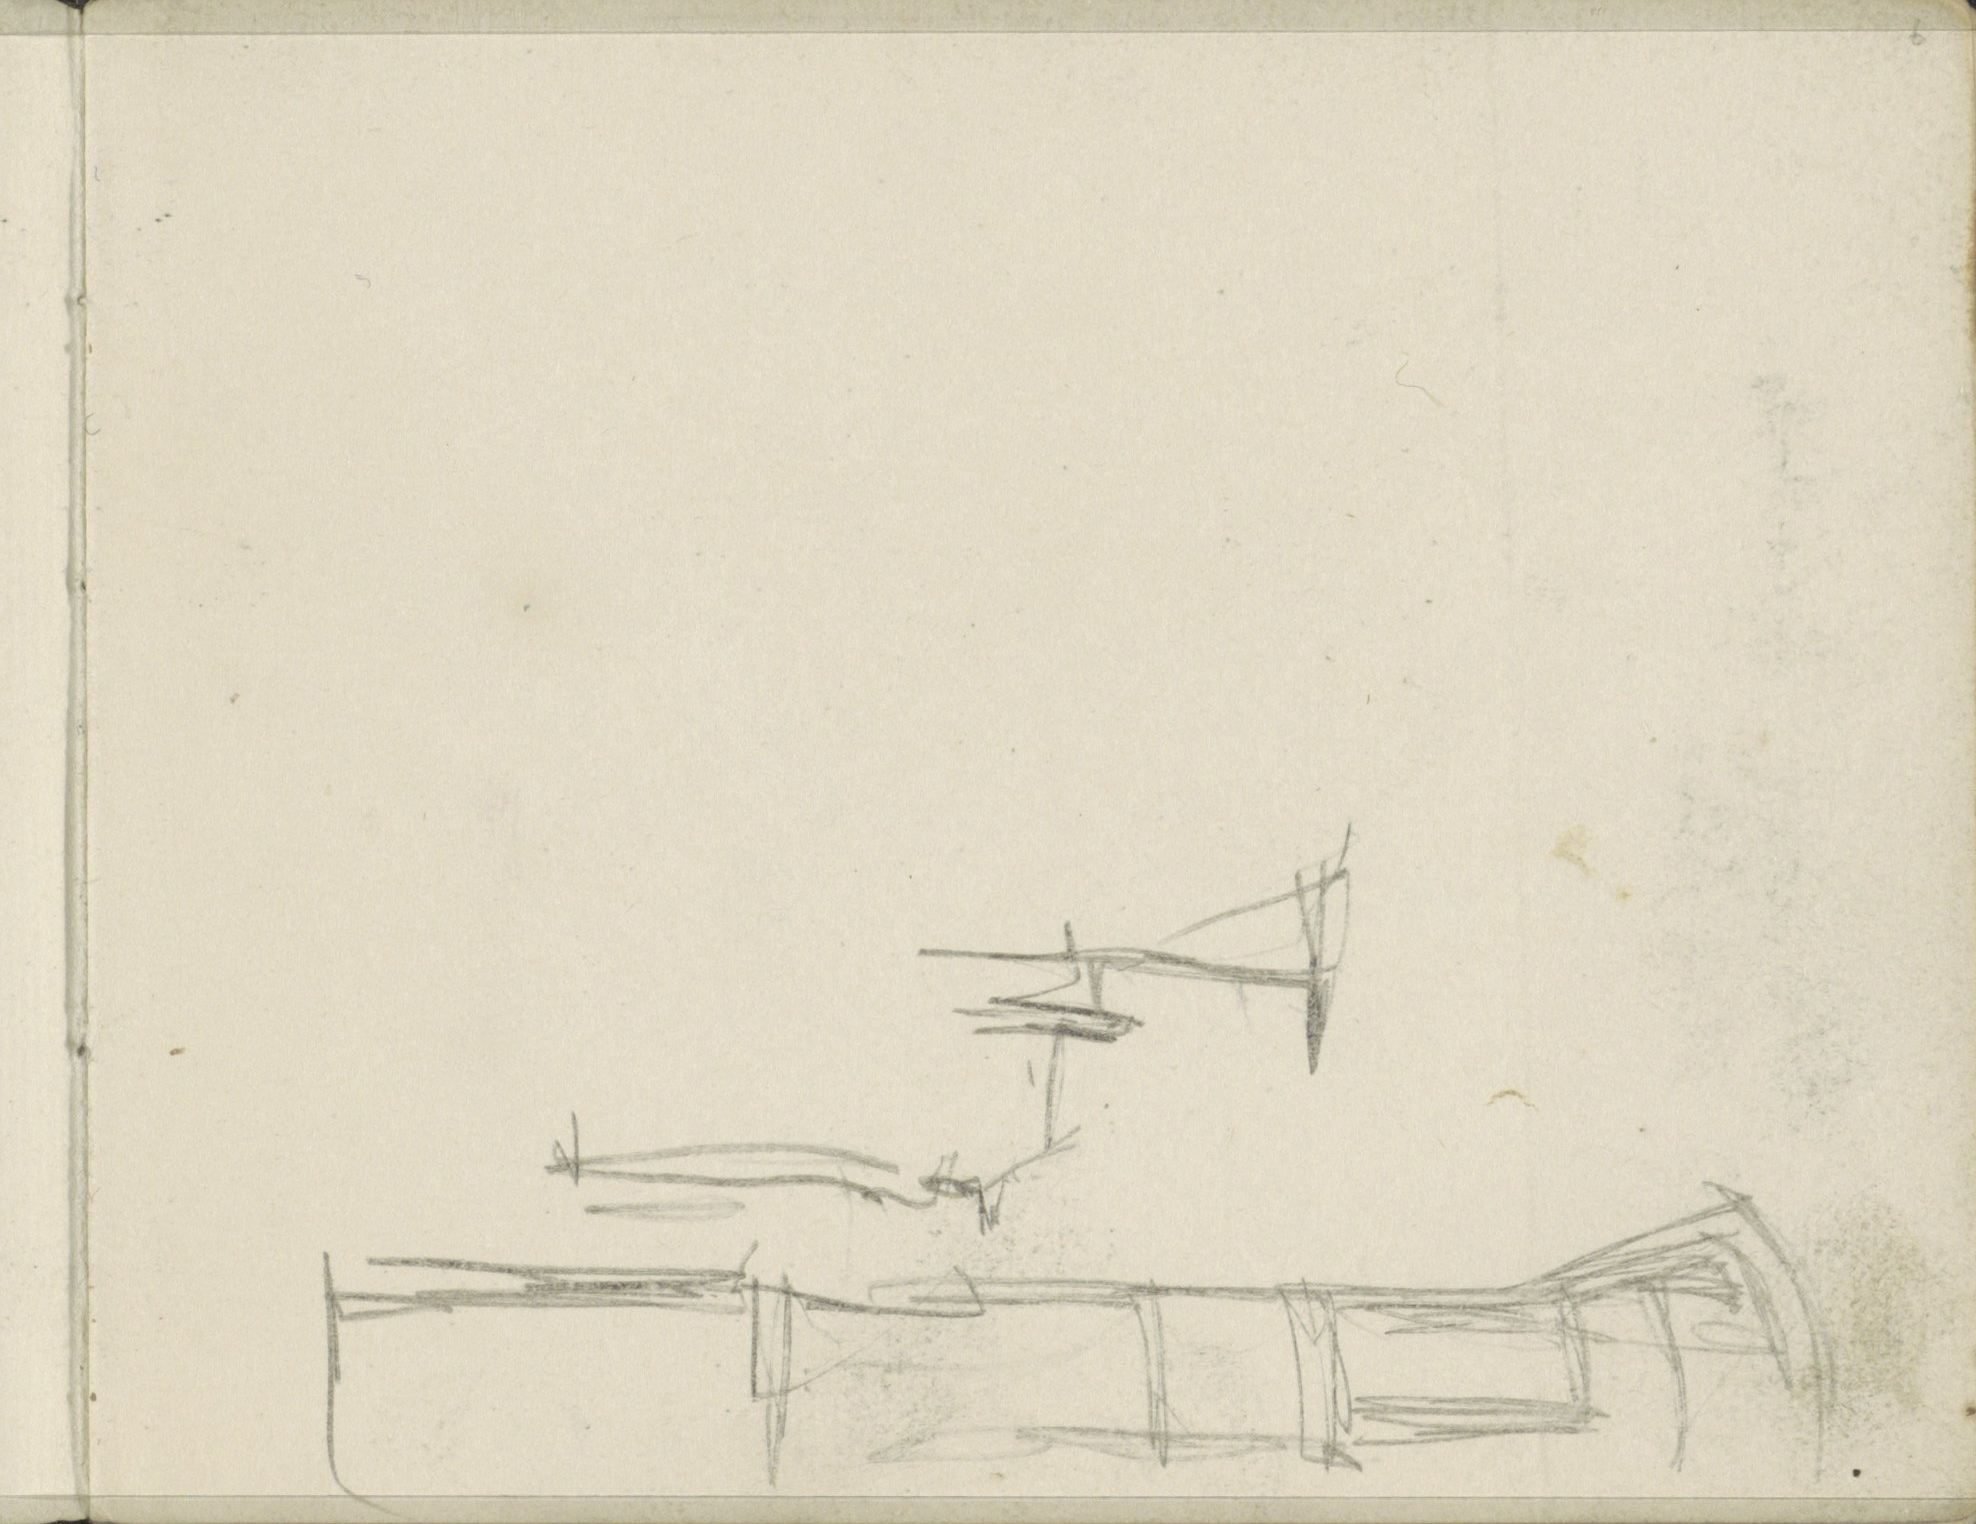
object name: sketchbook leaf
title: Gebouwen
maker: george hendrik breitner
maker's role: draughtsman, painter, print maker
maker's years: 1857-1923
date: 1886-1895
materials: paper, pencil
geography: amsterdam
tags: civic architecture; edifices; dwellings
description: Pagina 6 uit een schetsboek met 34 bladen.